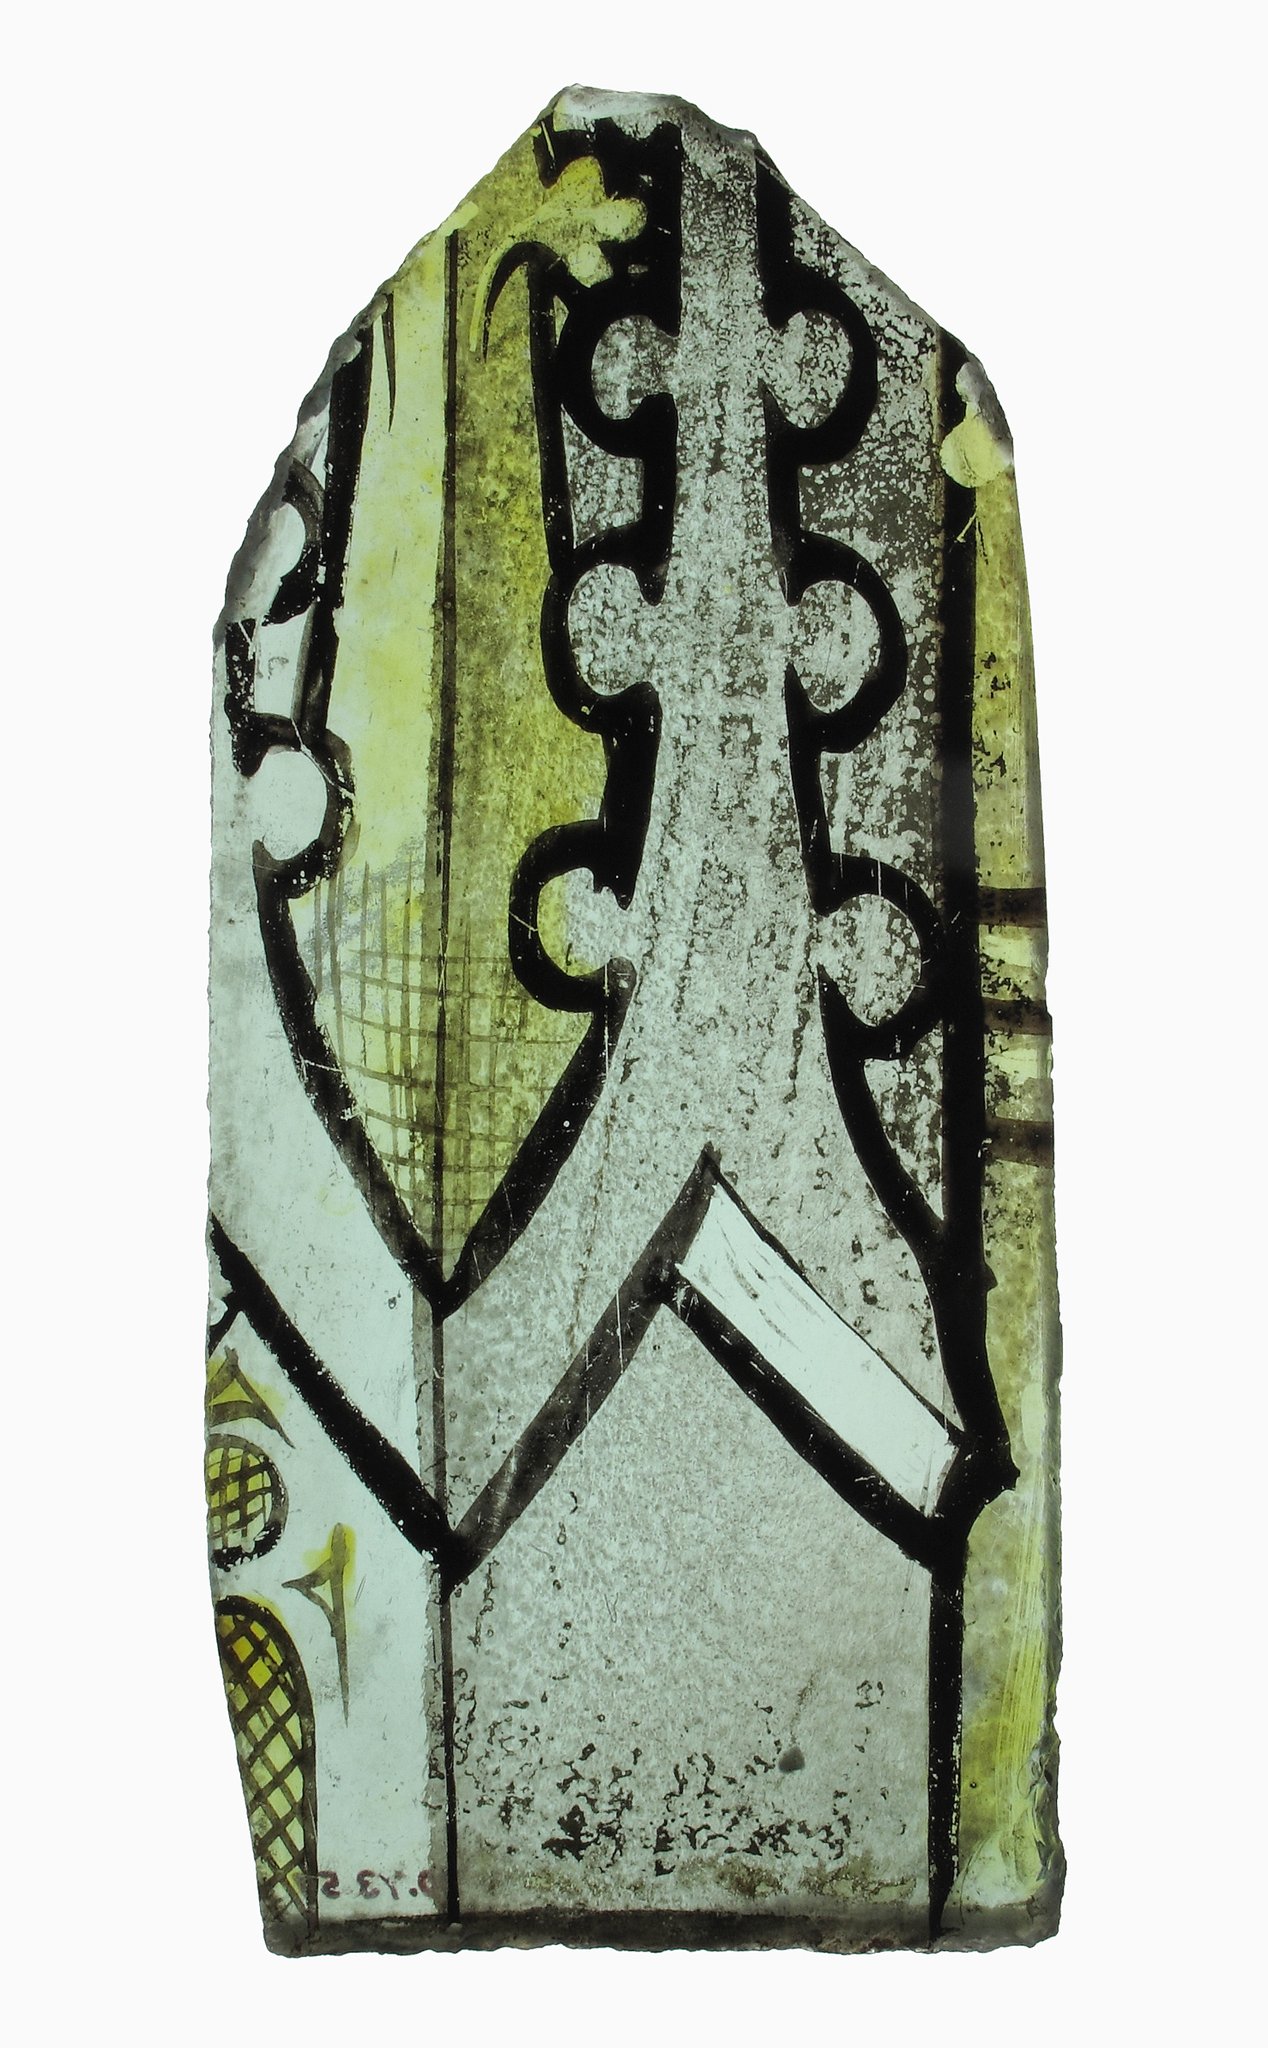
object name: fragment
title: Glass Fragment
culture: european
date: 1401-1500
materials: glass